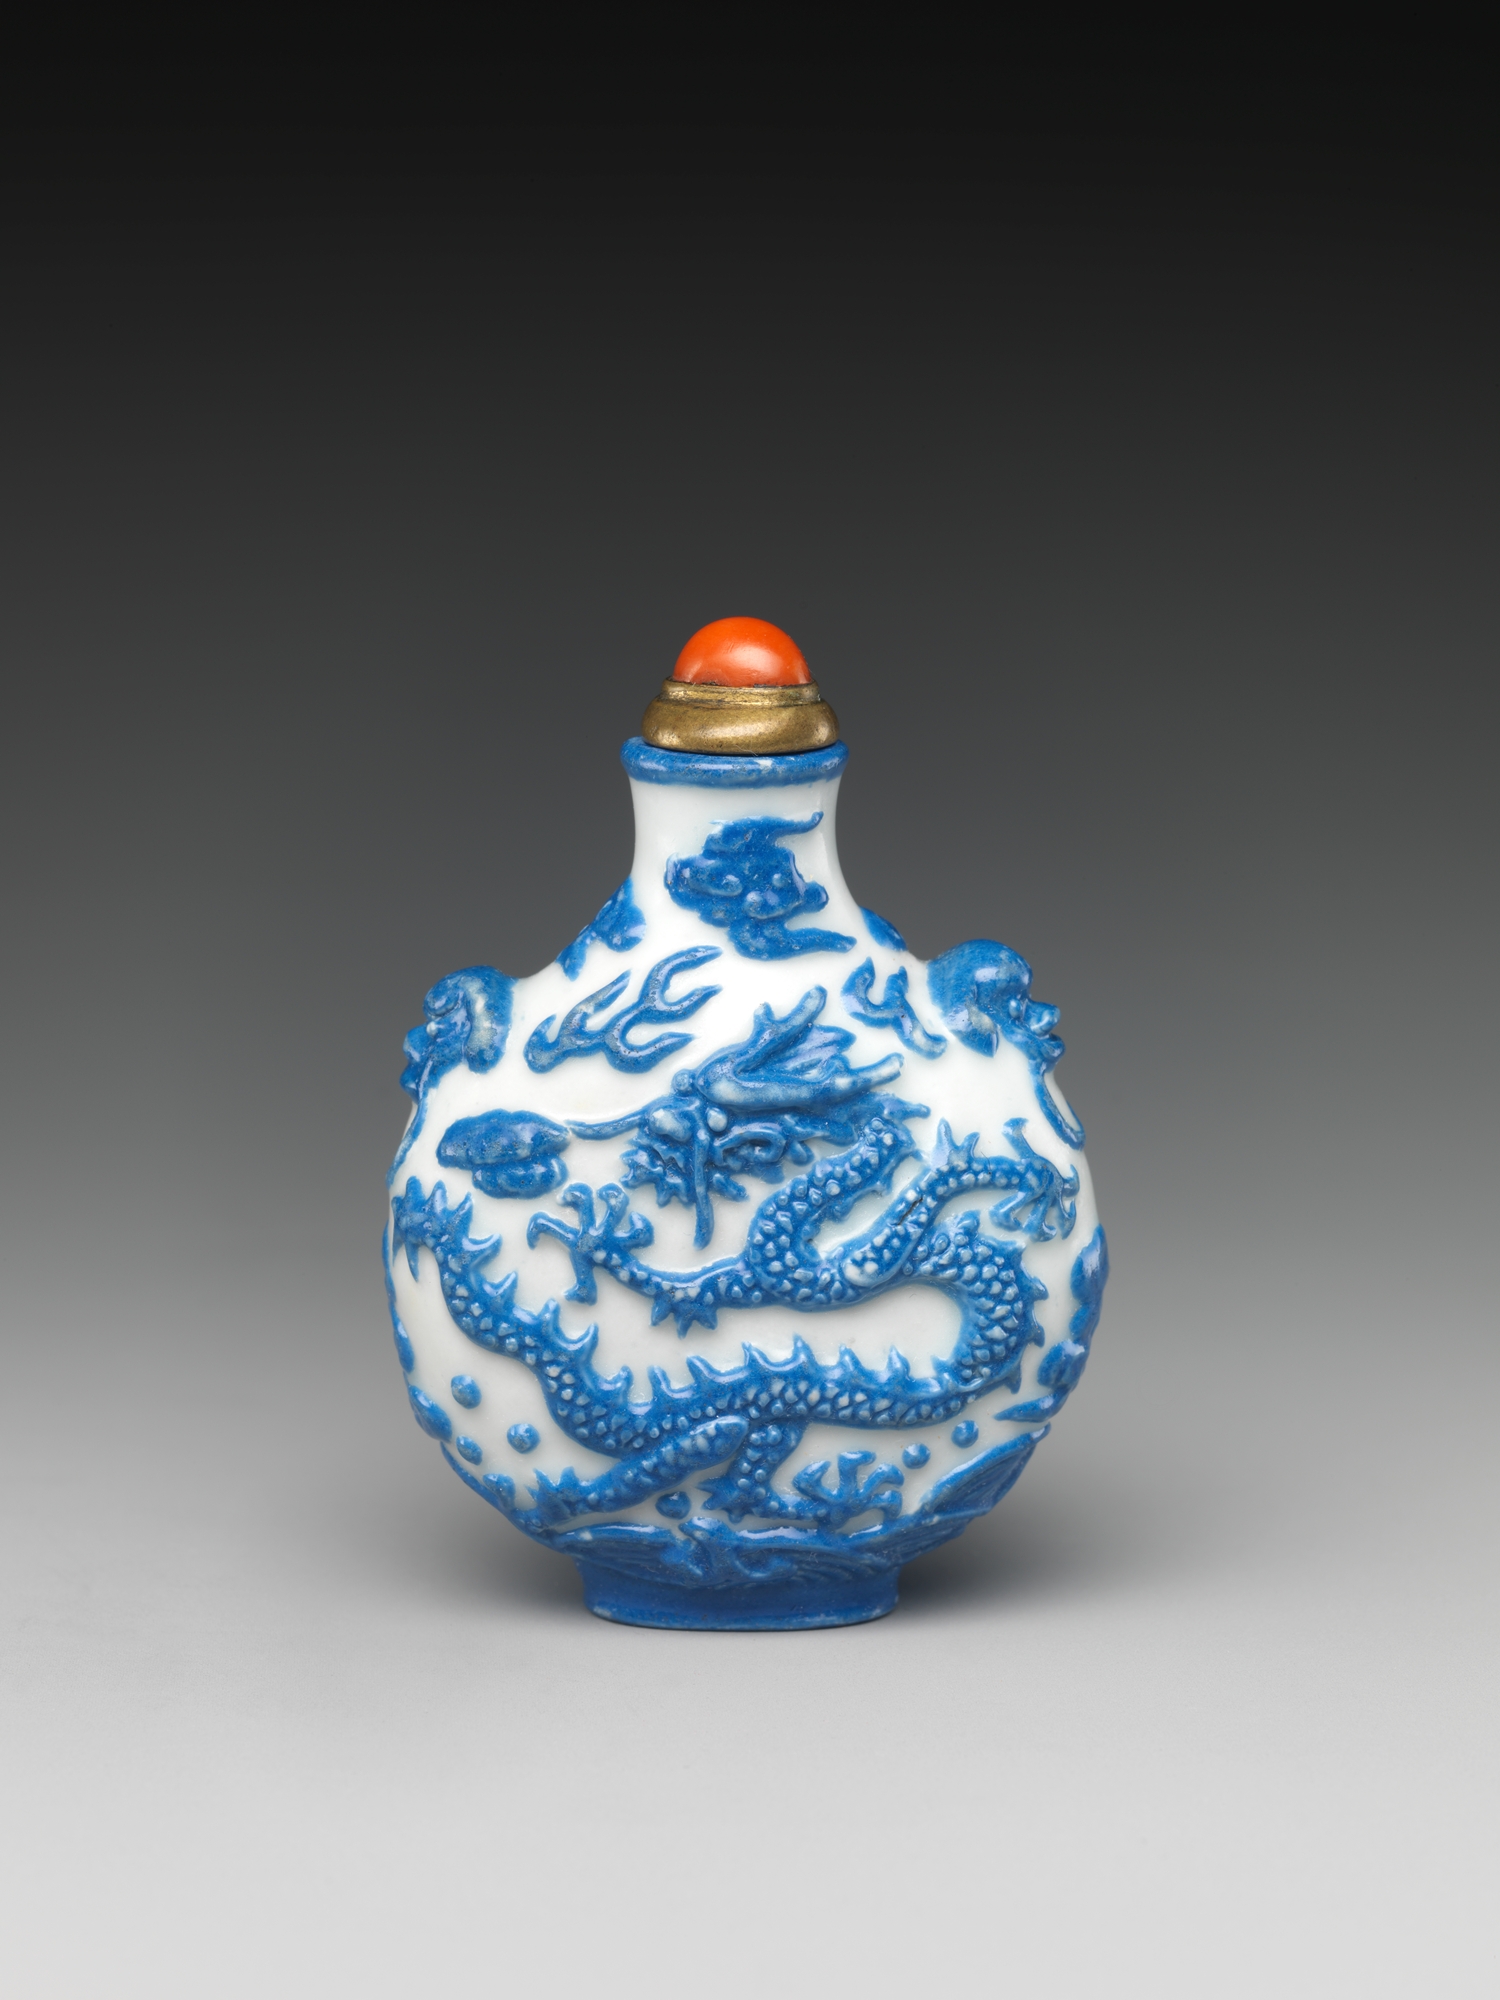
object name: snuff bottle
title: Snuff Bottle with Dragon Chasing a Flaming Pearl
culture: chinese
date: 1767-1833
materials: coral, glass, porcelain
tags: dragons